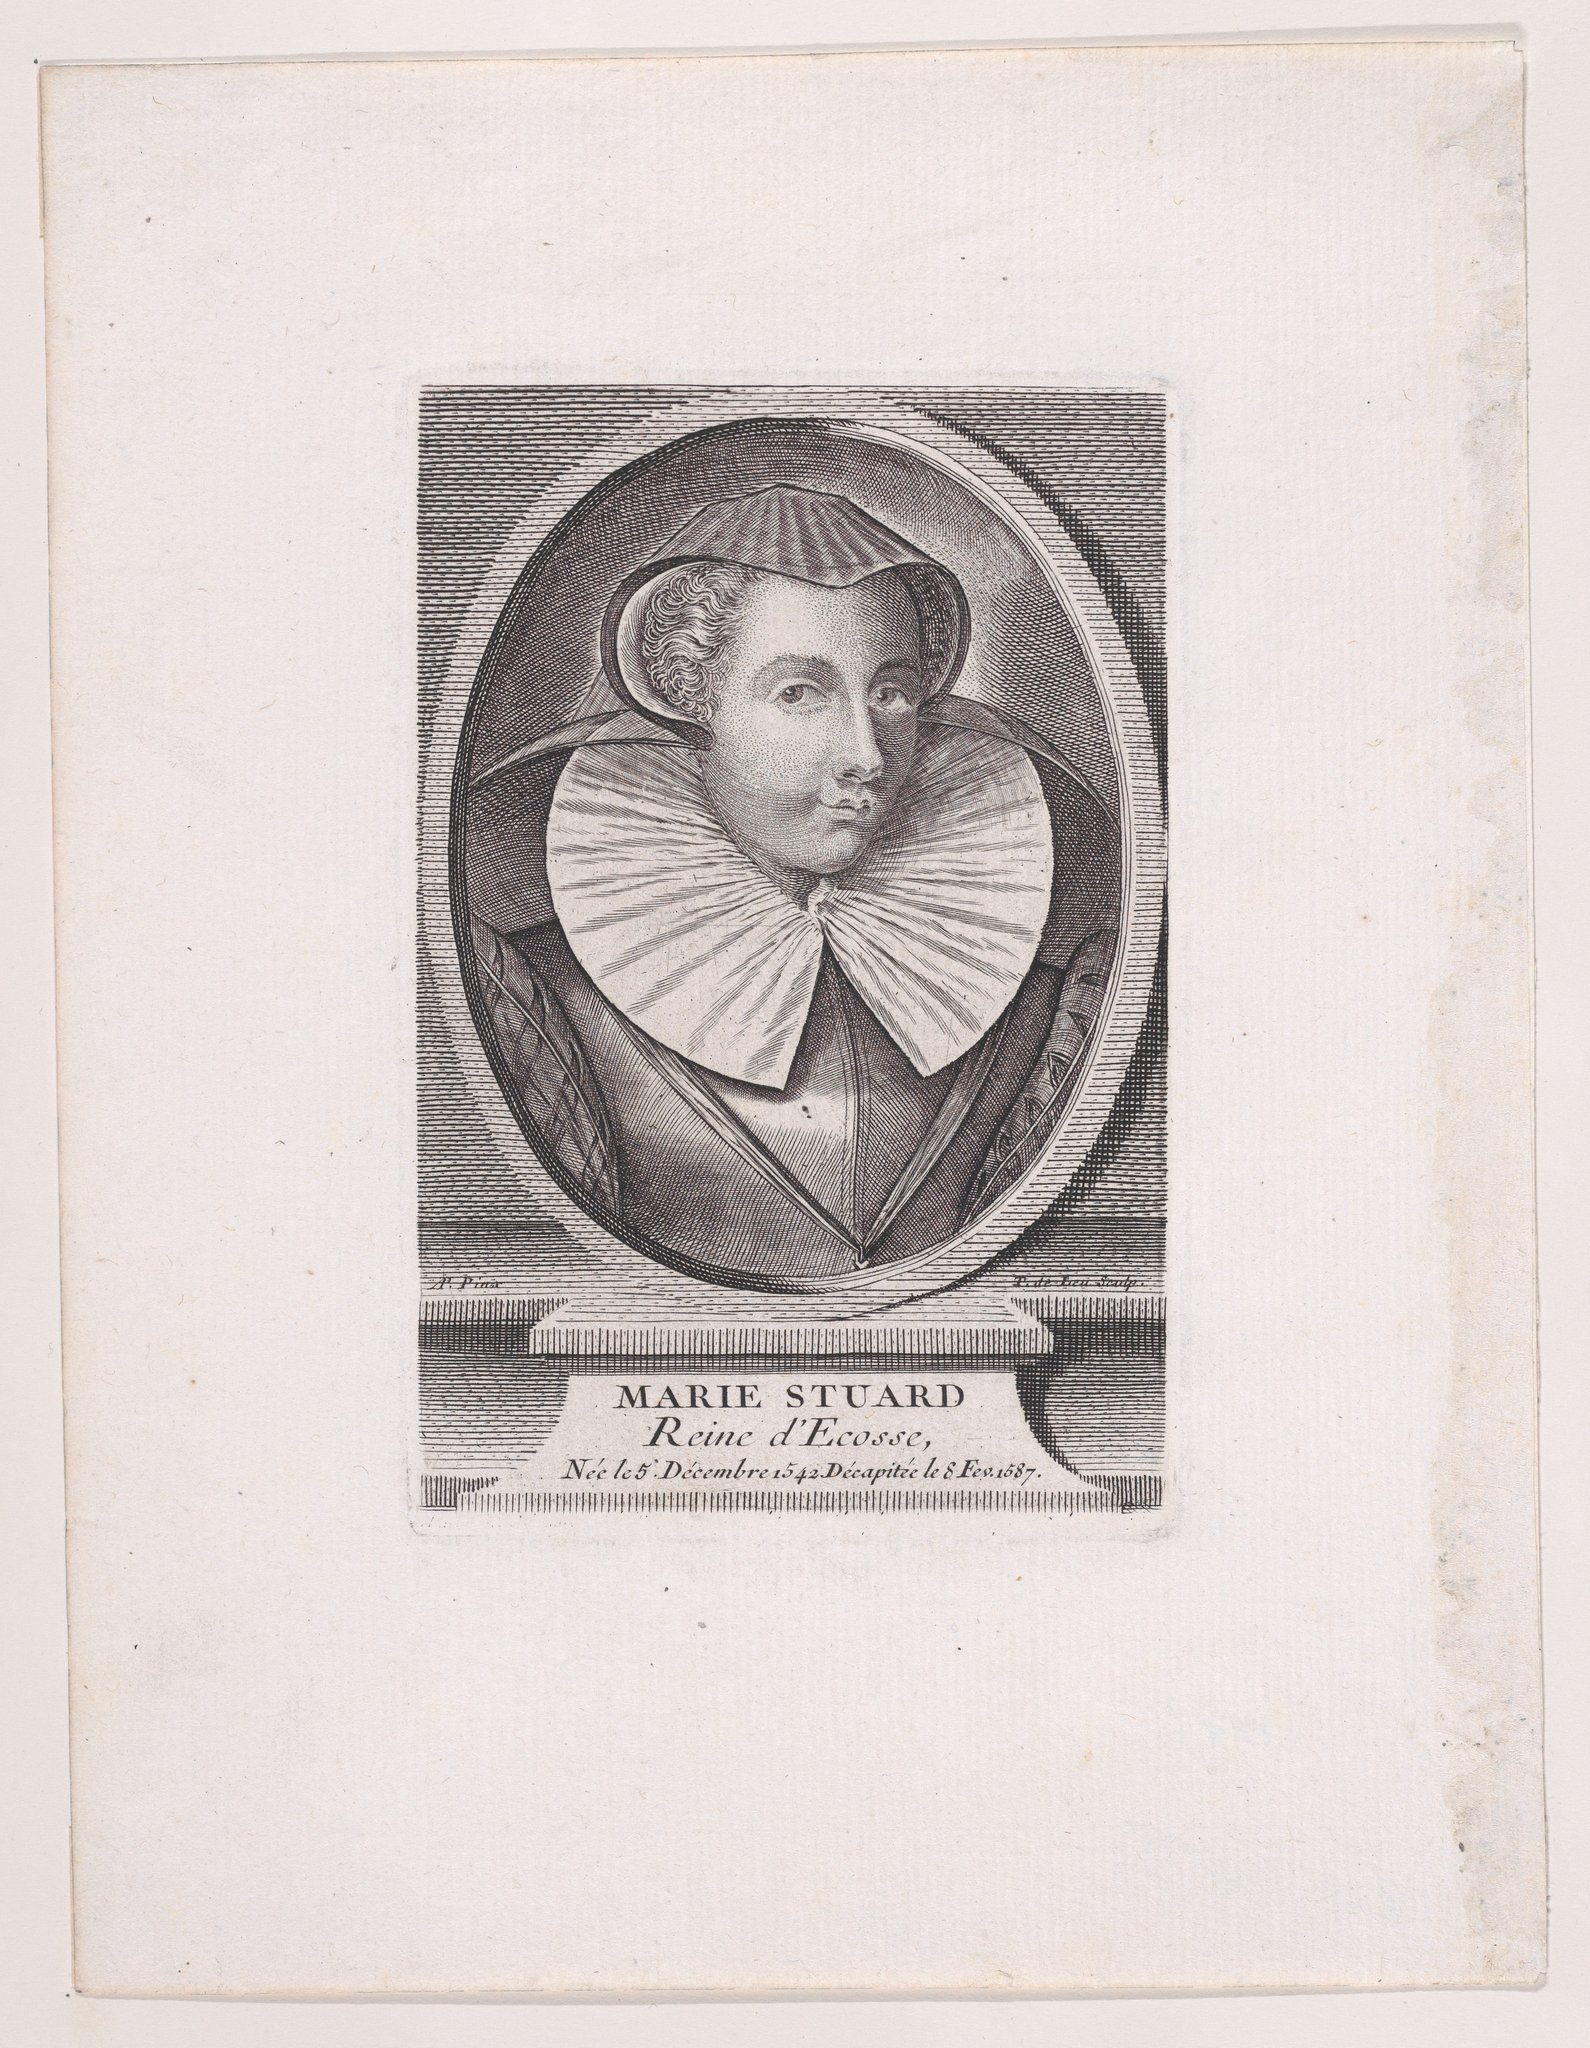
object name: print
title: Mary, Queen of Scots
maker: thomas de leu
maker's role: artist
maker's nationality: french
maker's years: 1560-1620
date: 1751-1800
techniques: engraving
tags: queens,portraits,women,mary queen of scots